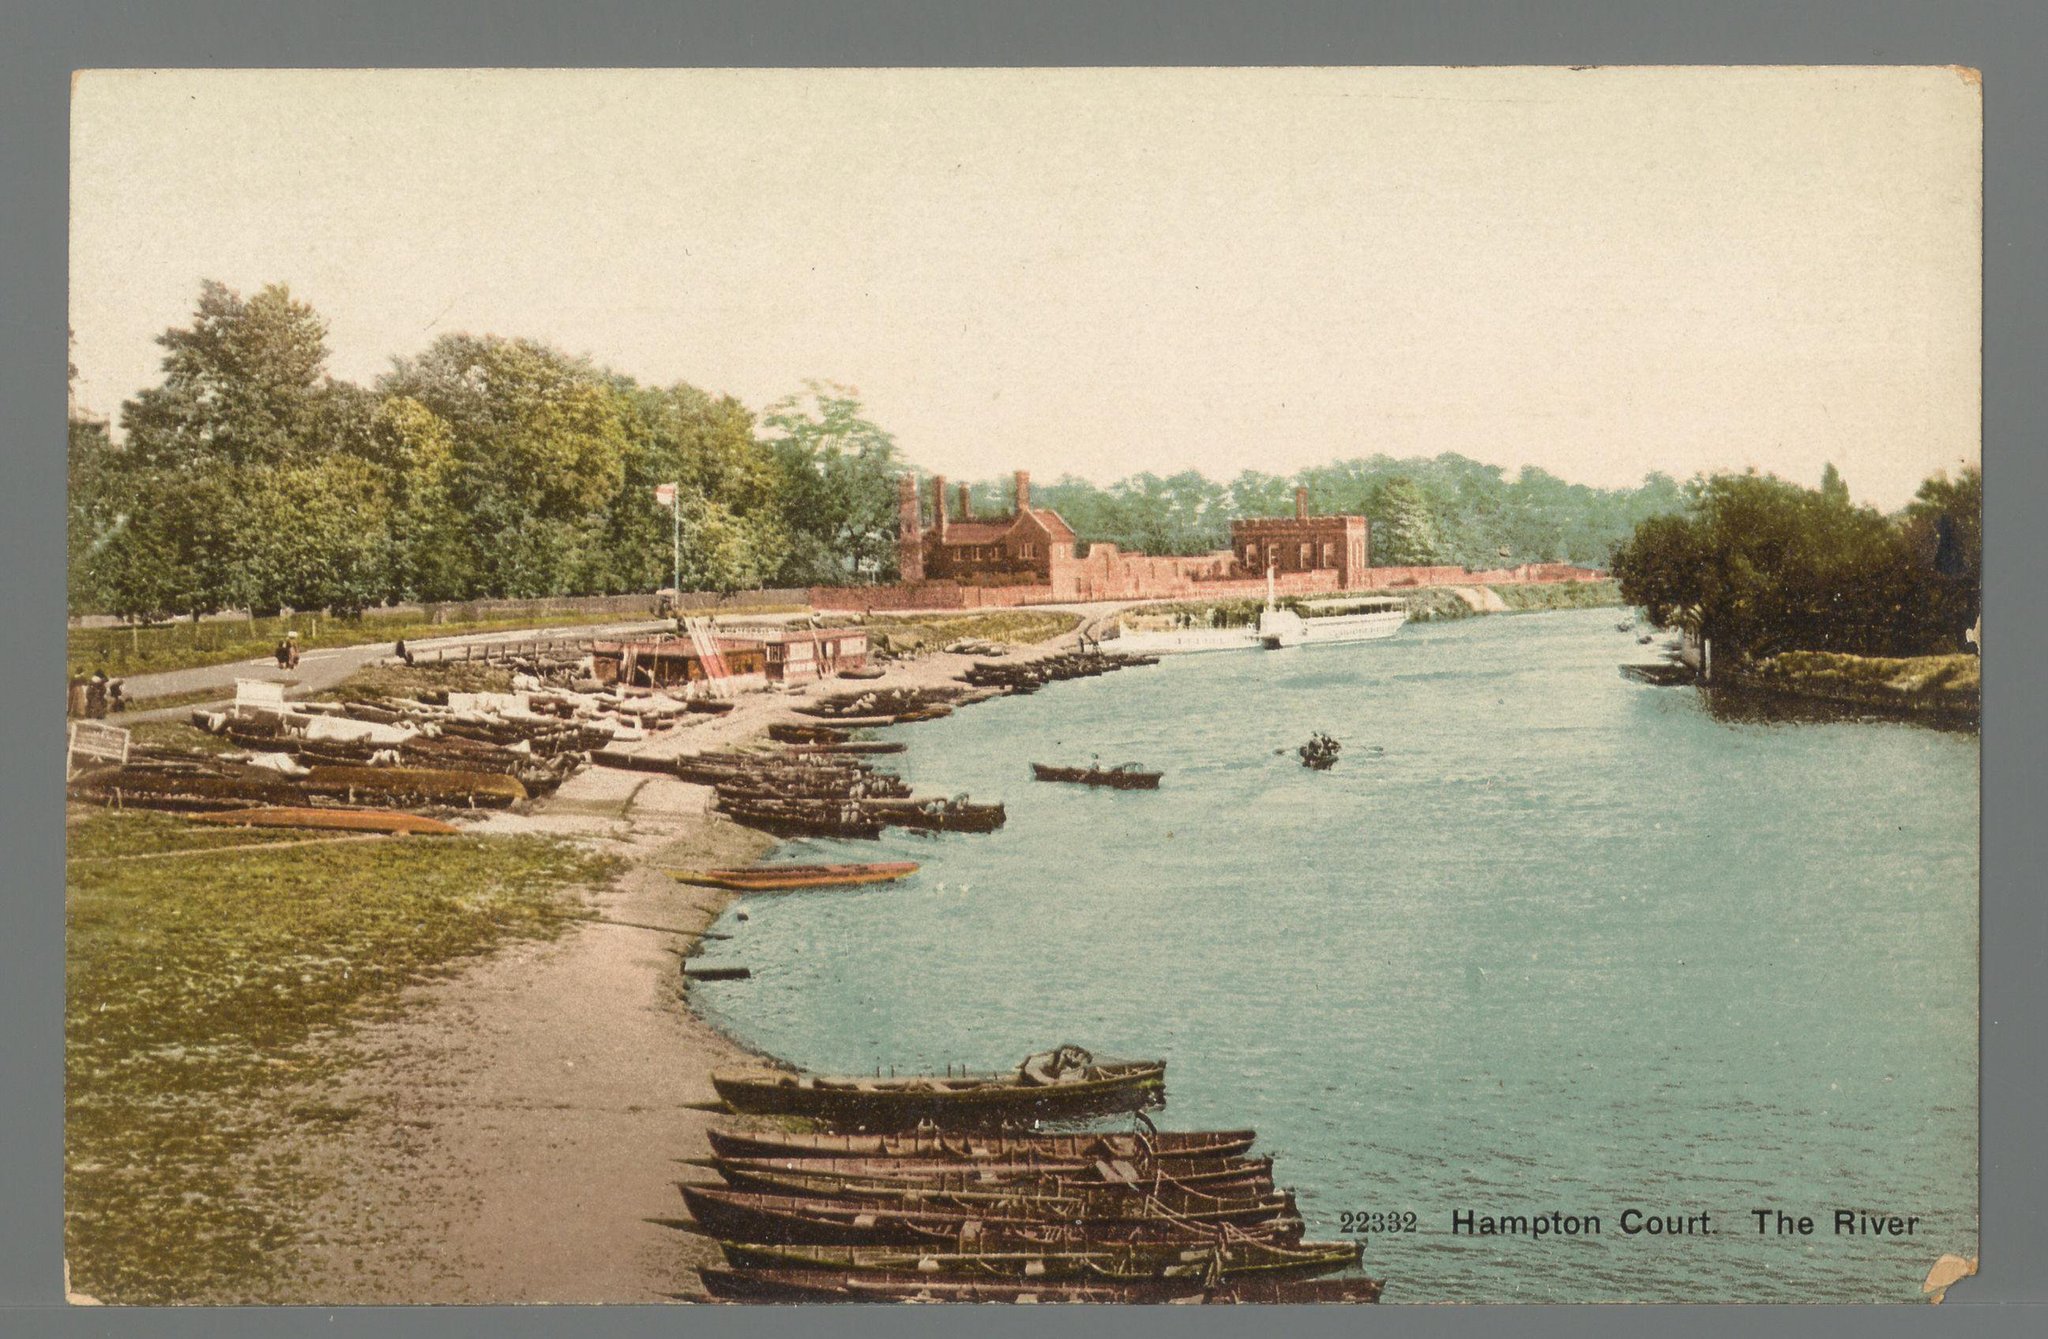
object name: photomechanical print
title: Hampton Court. The River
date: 1902-1918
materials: cardboard, photographic process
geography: hampton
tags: river, palace, rowing-boat, canoe, etc., thames